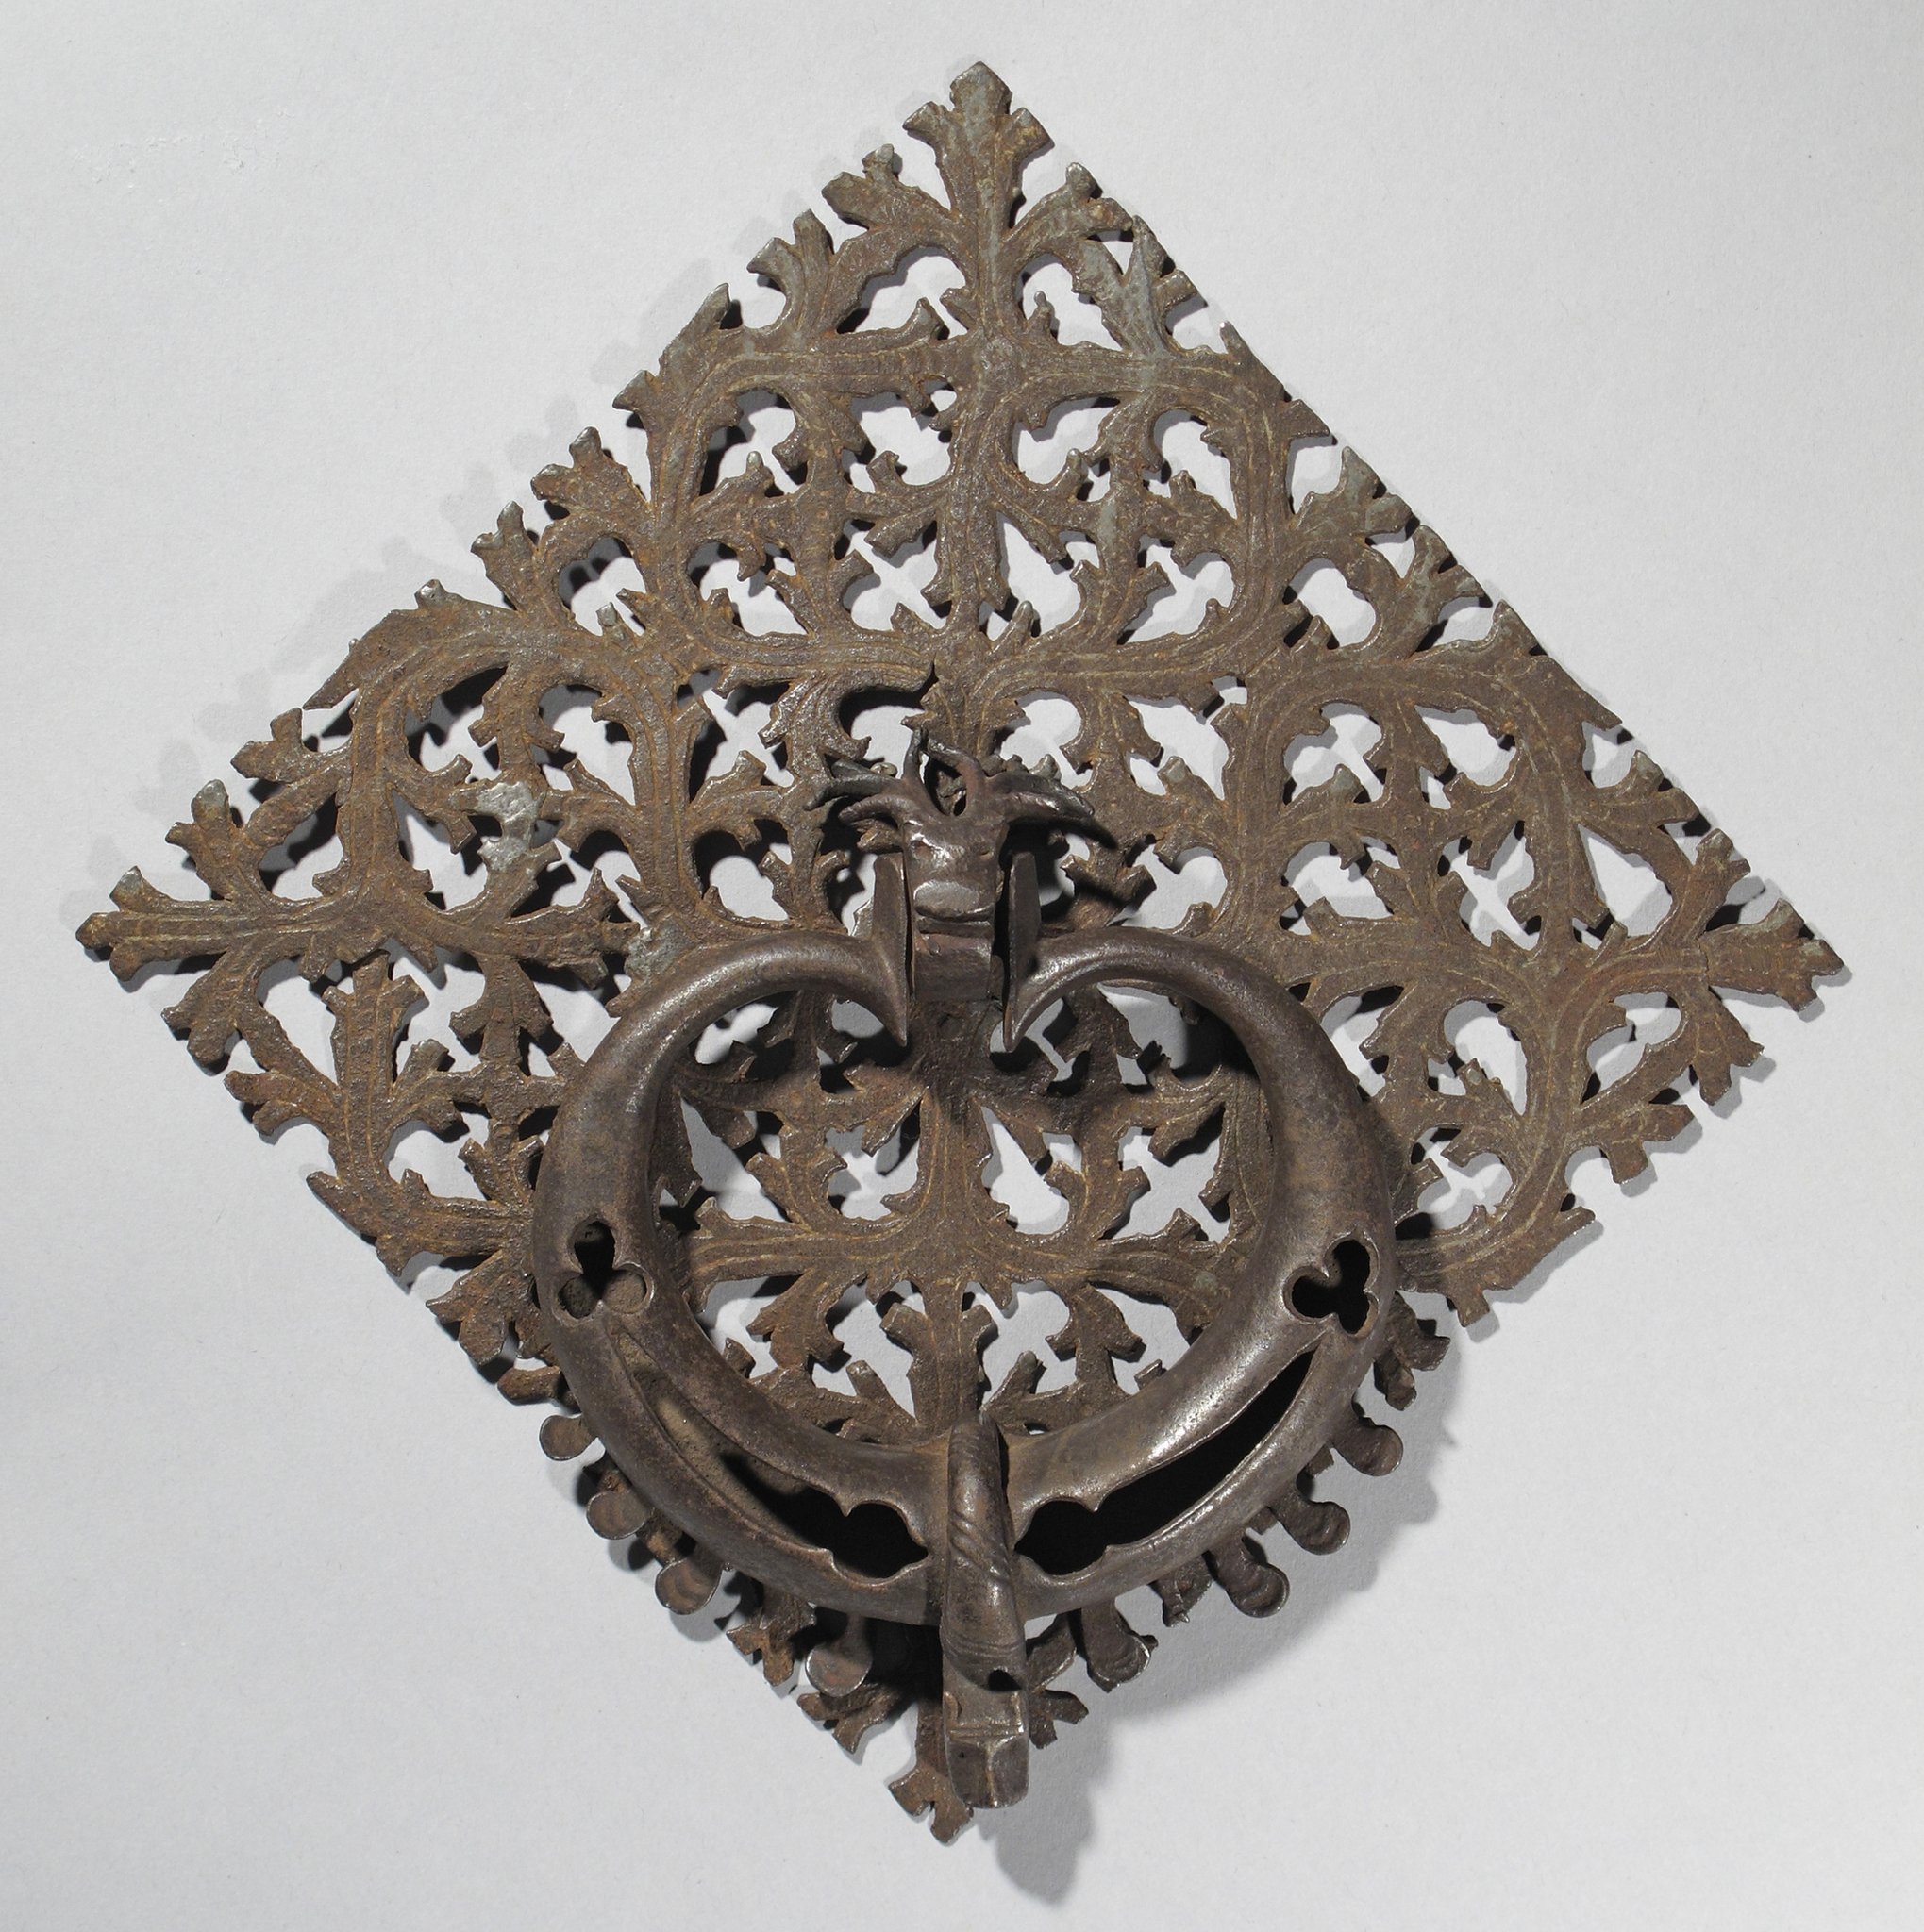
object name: door knocker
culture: european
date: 1401-1600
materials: iron